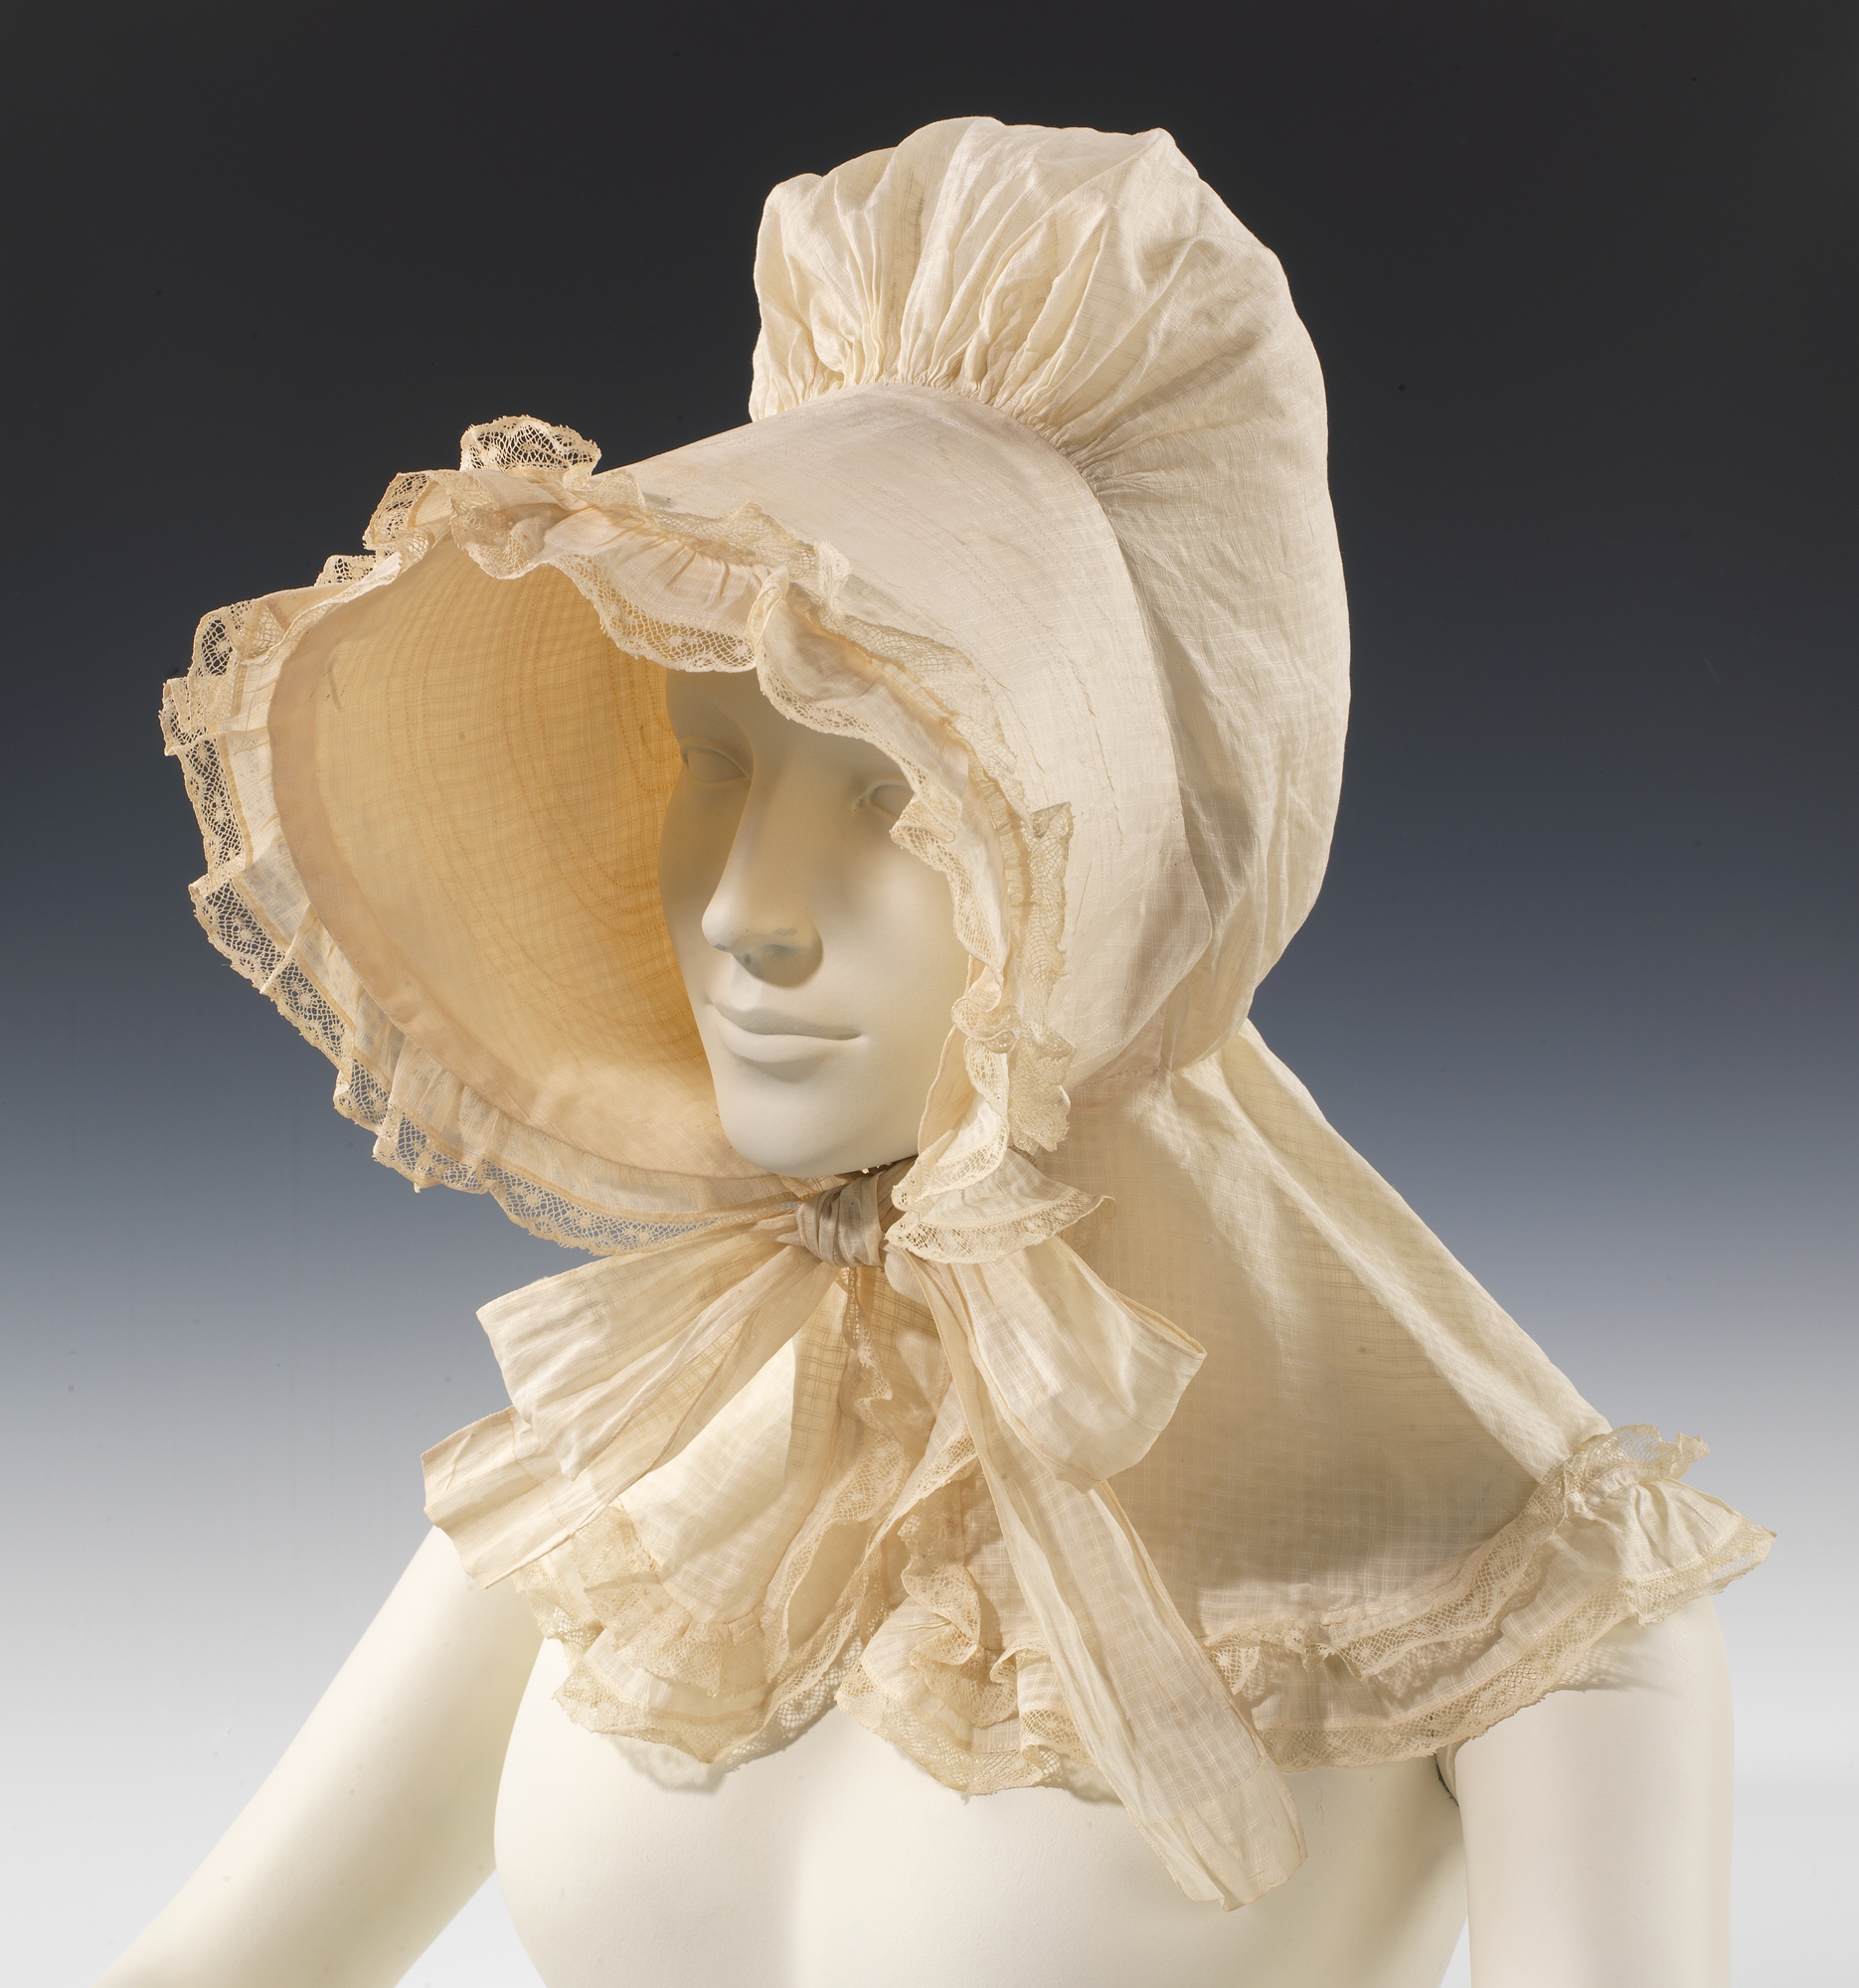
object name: sunbonnet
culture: american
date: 1835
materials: cotton